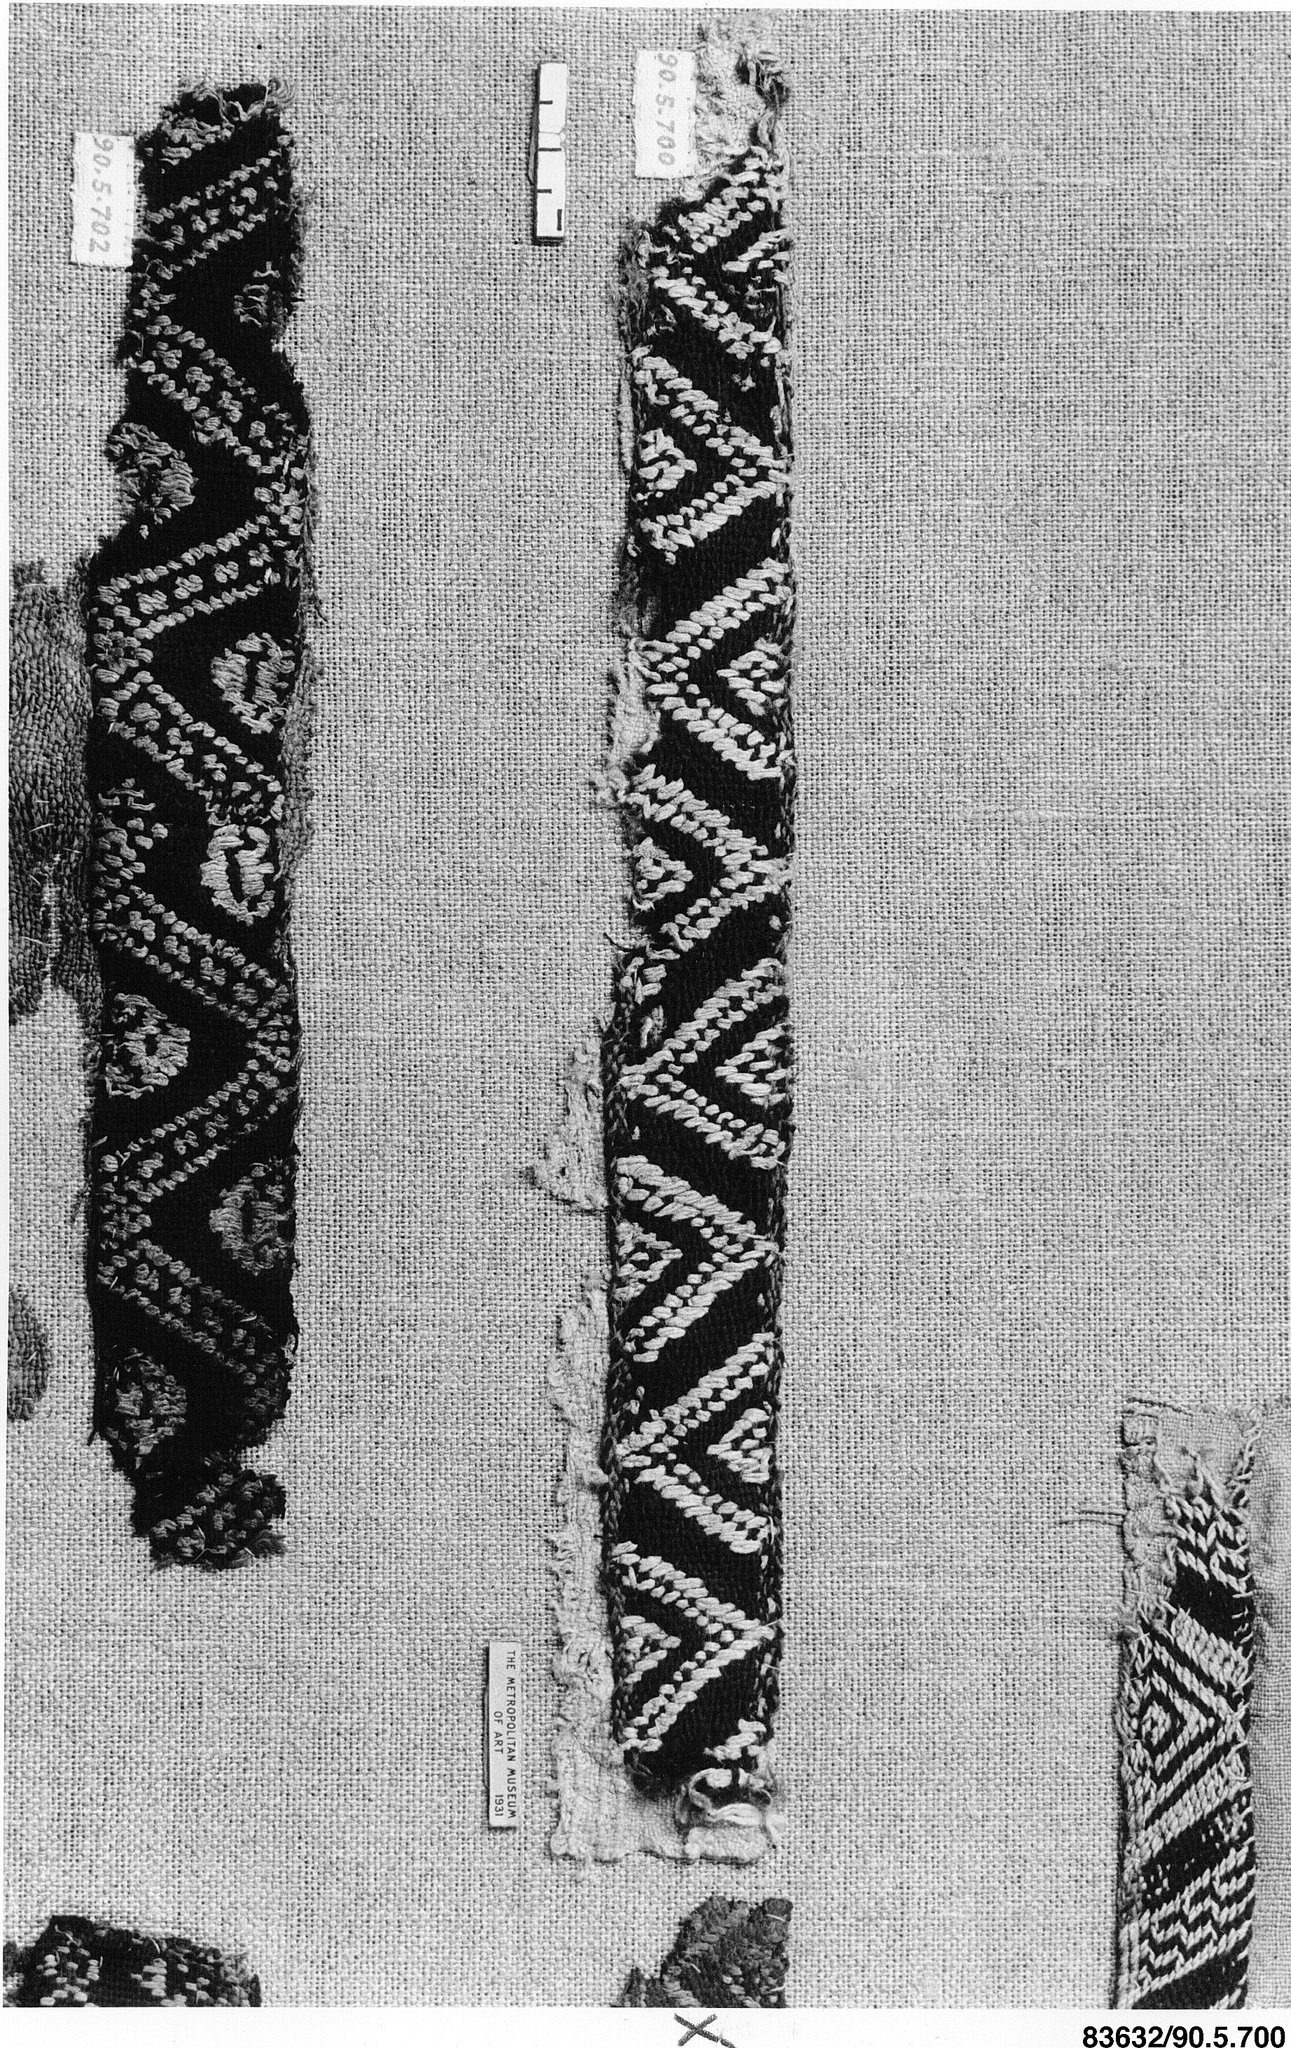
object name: textile fragment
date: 401-600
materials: linen, wool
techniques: weave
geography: egypt